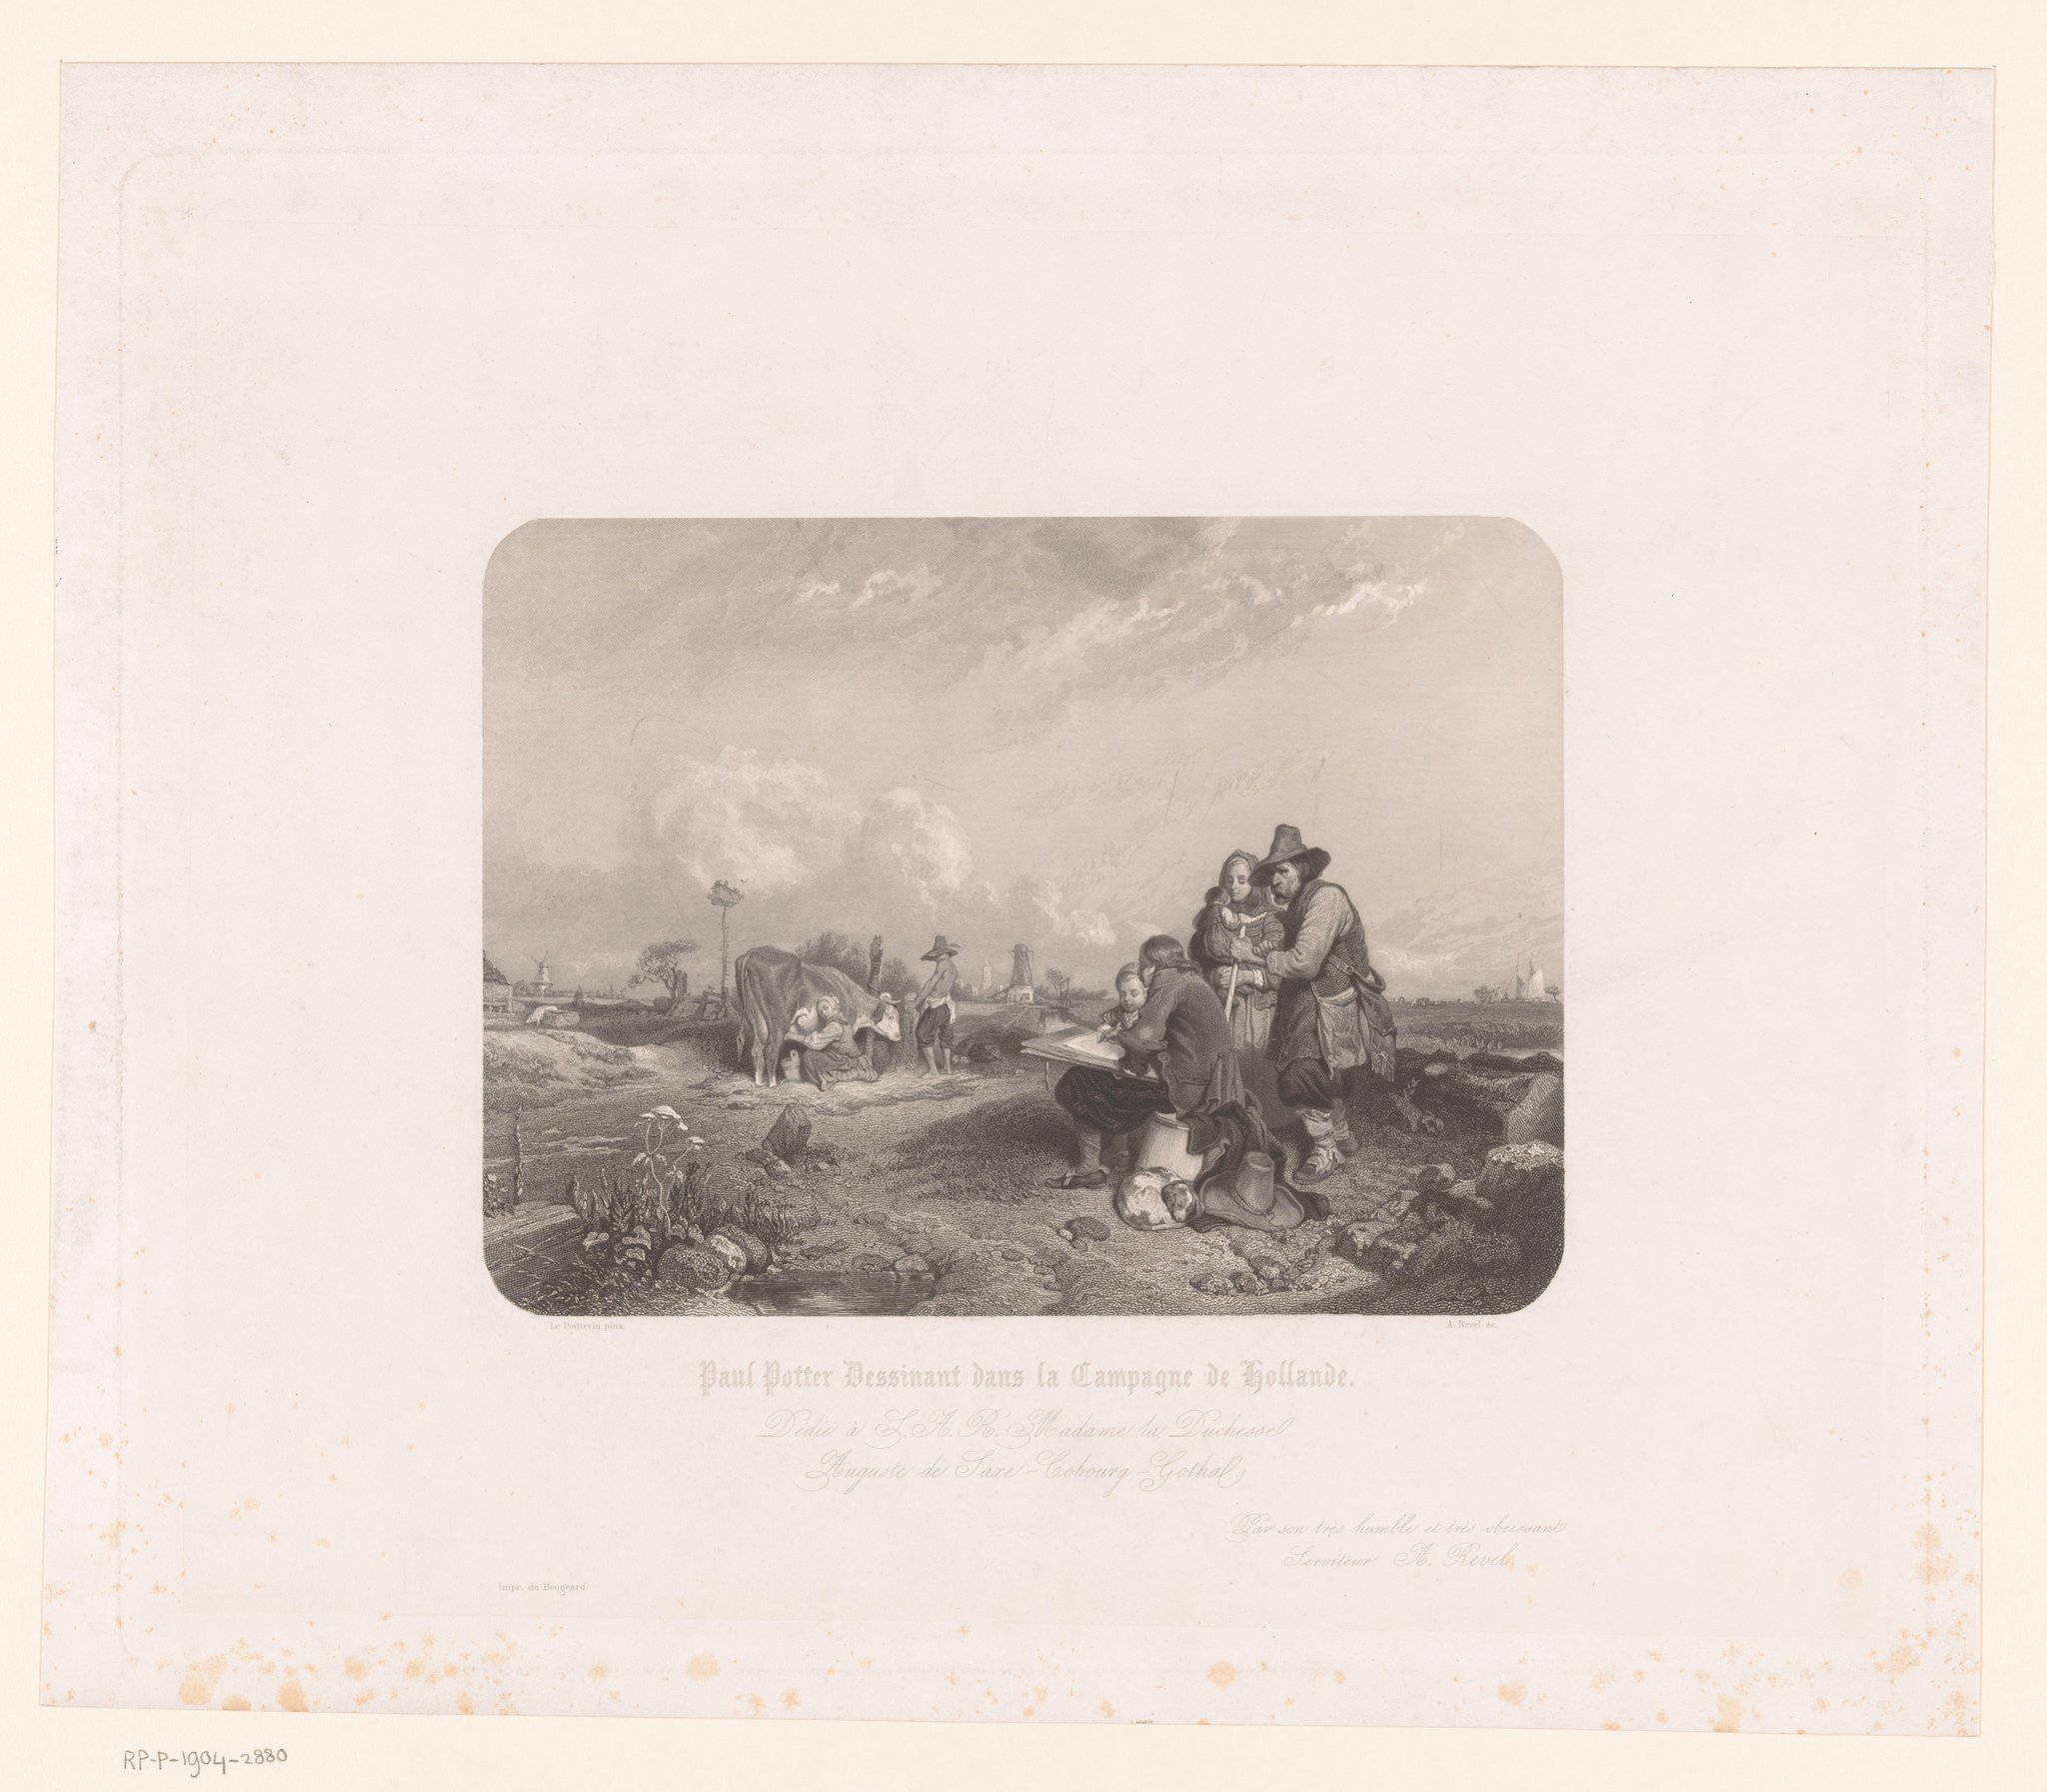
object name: print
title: Paul Potter Dessinant dans la Campagne de Hollande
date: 1765-1865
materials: paper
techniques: engraving, etching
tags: artist (in general) making preliminary designs, sketching - bb - out of doors, milking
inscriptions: collector's mark: Lugt, check stamp: Lugt 3977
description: Landschap met schetsende man, naast hem een kind, een man en een vrouw met kind op de arm.